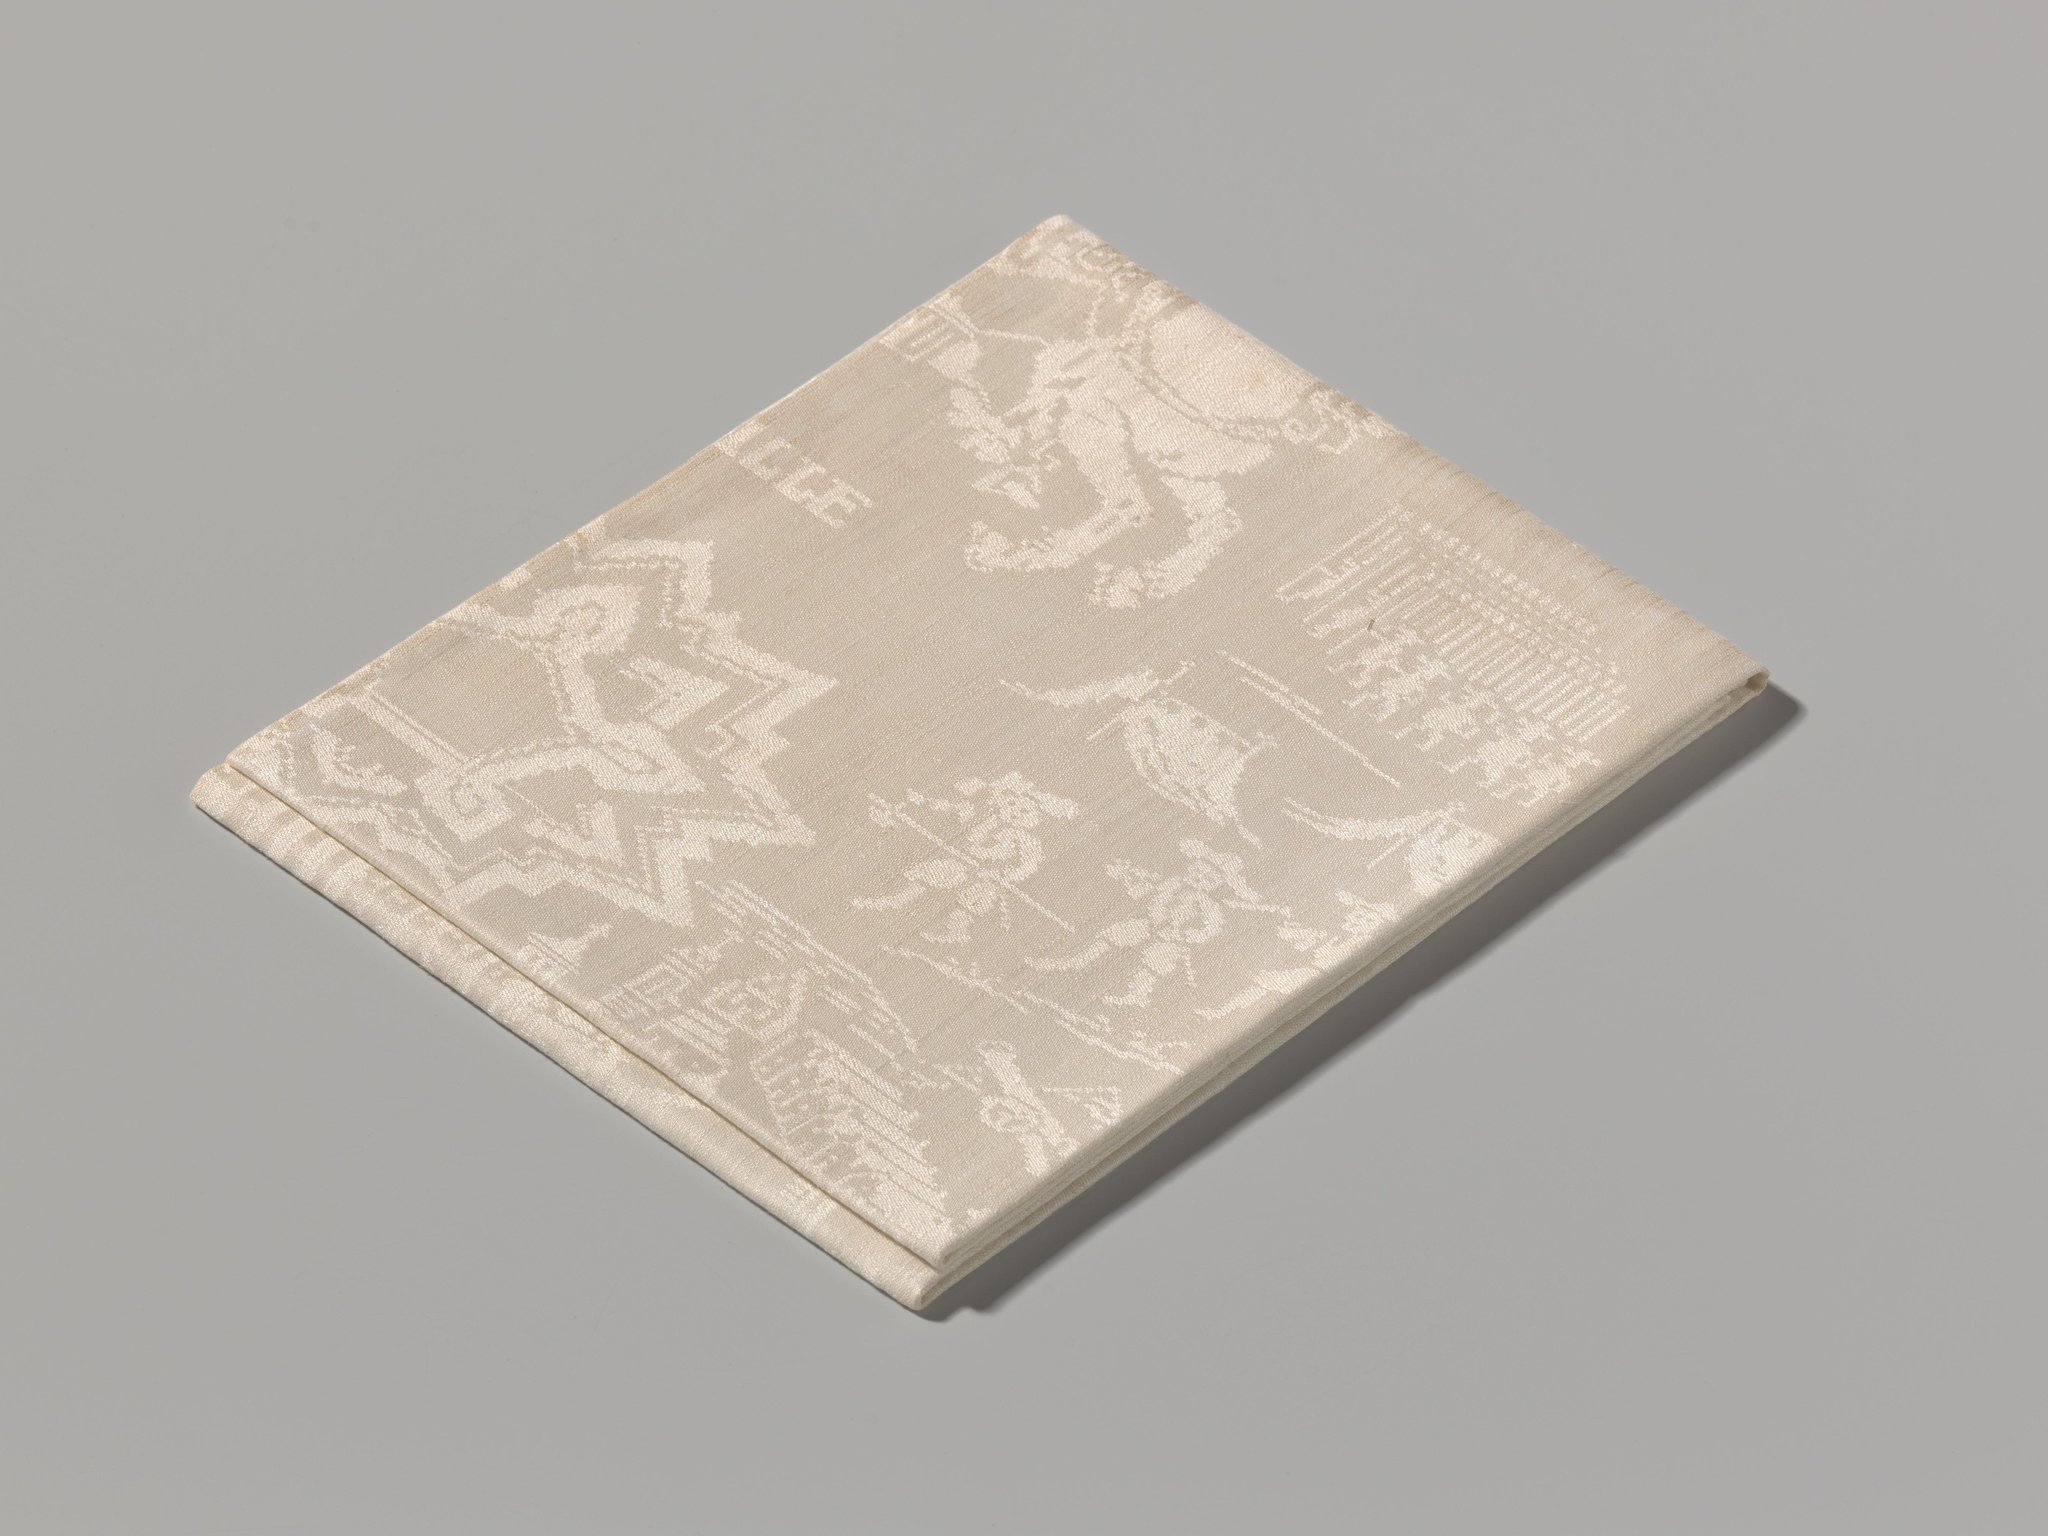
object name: napkin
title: Servet met het wapen van Karel III van Spanje en een gezicht op Rijssel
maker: Anonymous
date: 1702-1713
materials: linen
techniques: damask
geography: kortrijk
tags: charles vi (holy roman emperor), lille, spain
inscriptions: mark: ‘? S’, mark: ‘13’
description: Servet van linnendamast met het wapen van Karel III van Spanje en een gezicht op Rijssel. Het symmetrisch patroon vertoont van onder naar boven de volgende taferelen: 1 Een gezicht op Rijssel met vele torens. 2 Plattegrond van een vesting met bovenschrift LILLE. 3 Ruiter te paard (Karel III van Spanje?). 4 Het wapen van Karel III van Spanje geflankeerd door vaandels. Staande en liggende randen: wapens, onder andere Savoye, en wapentrofeeën; daarbuiten: blokkenrand.